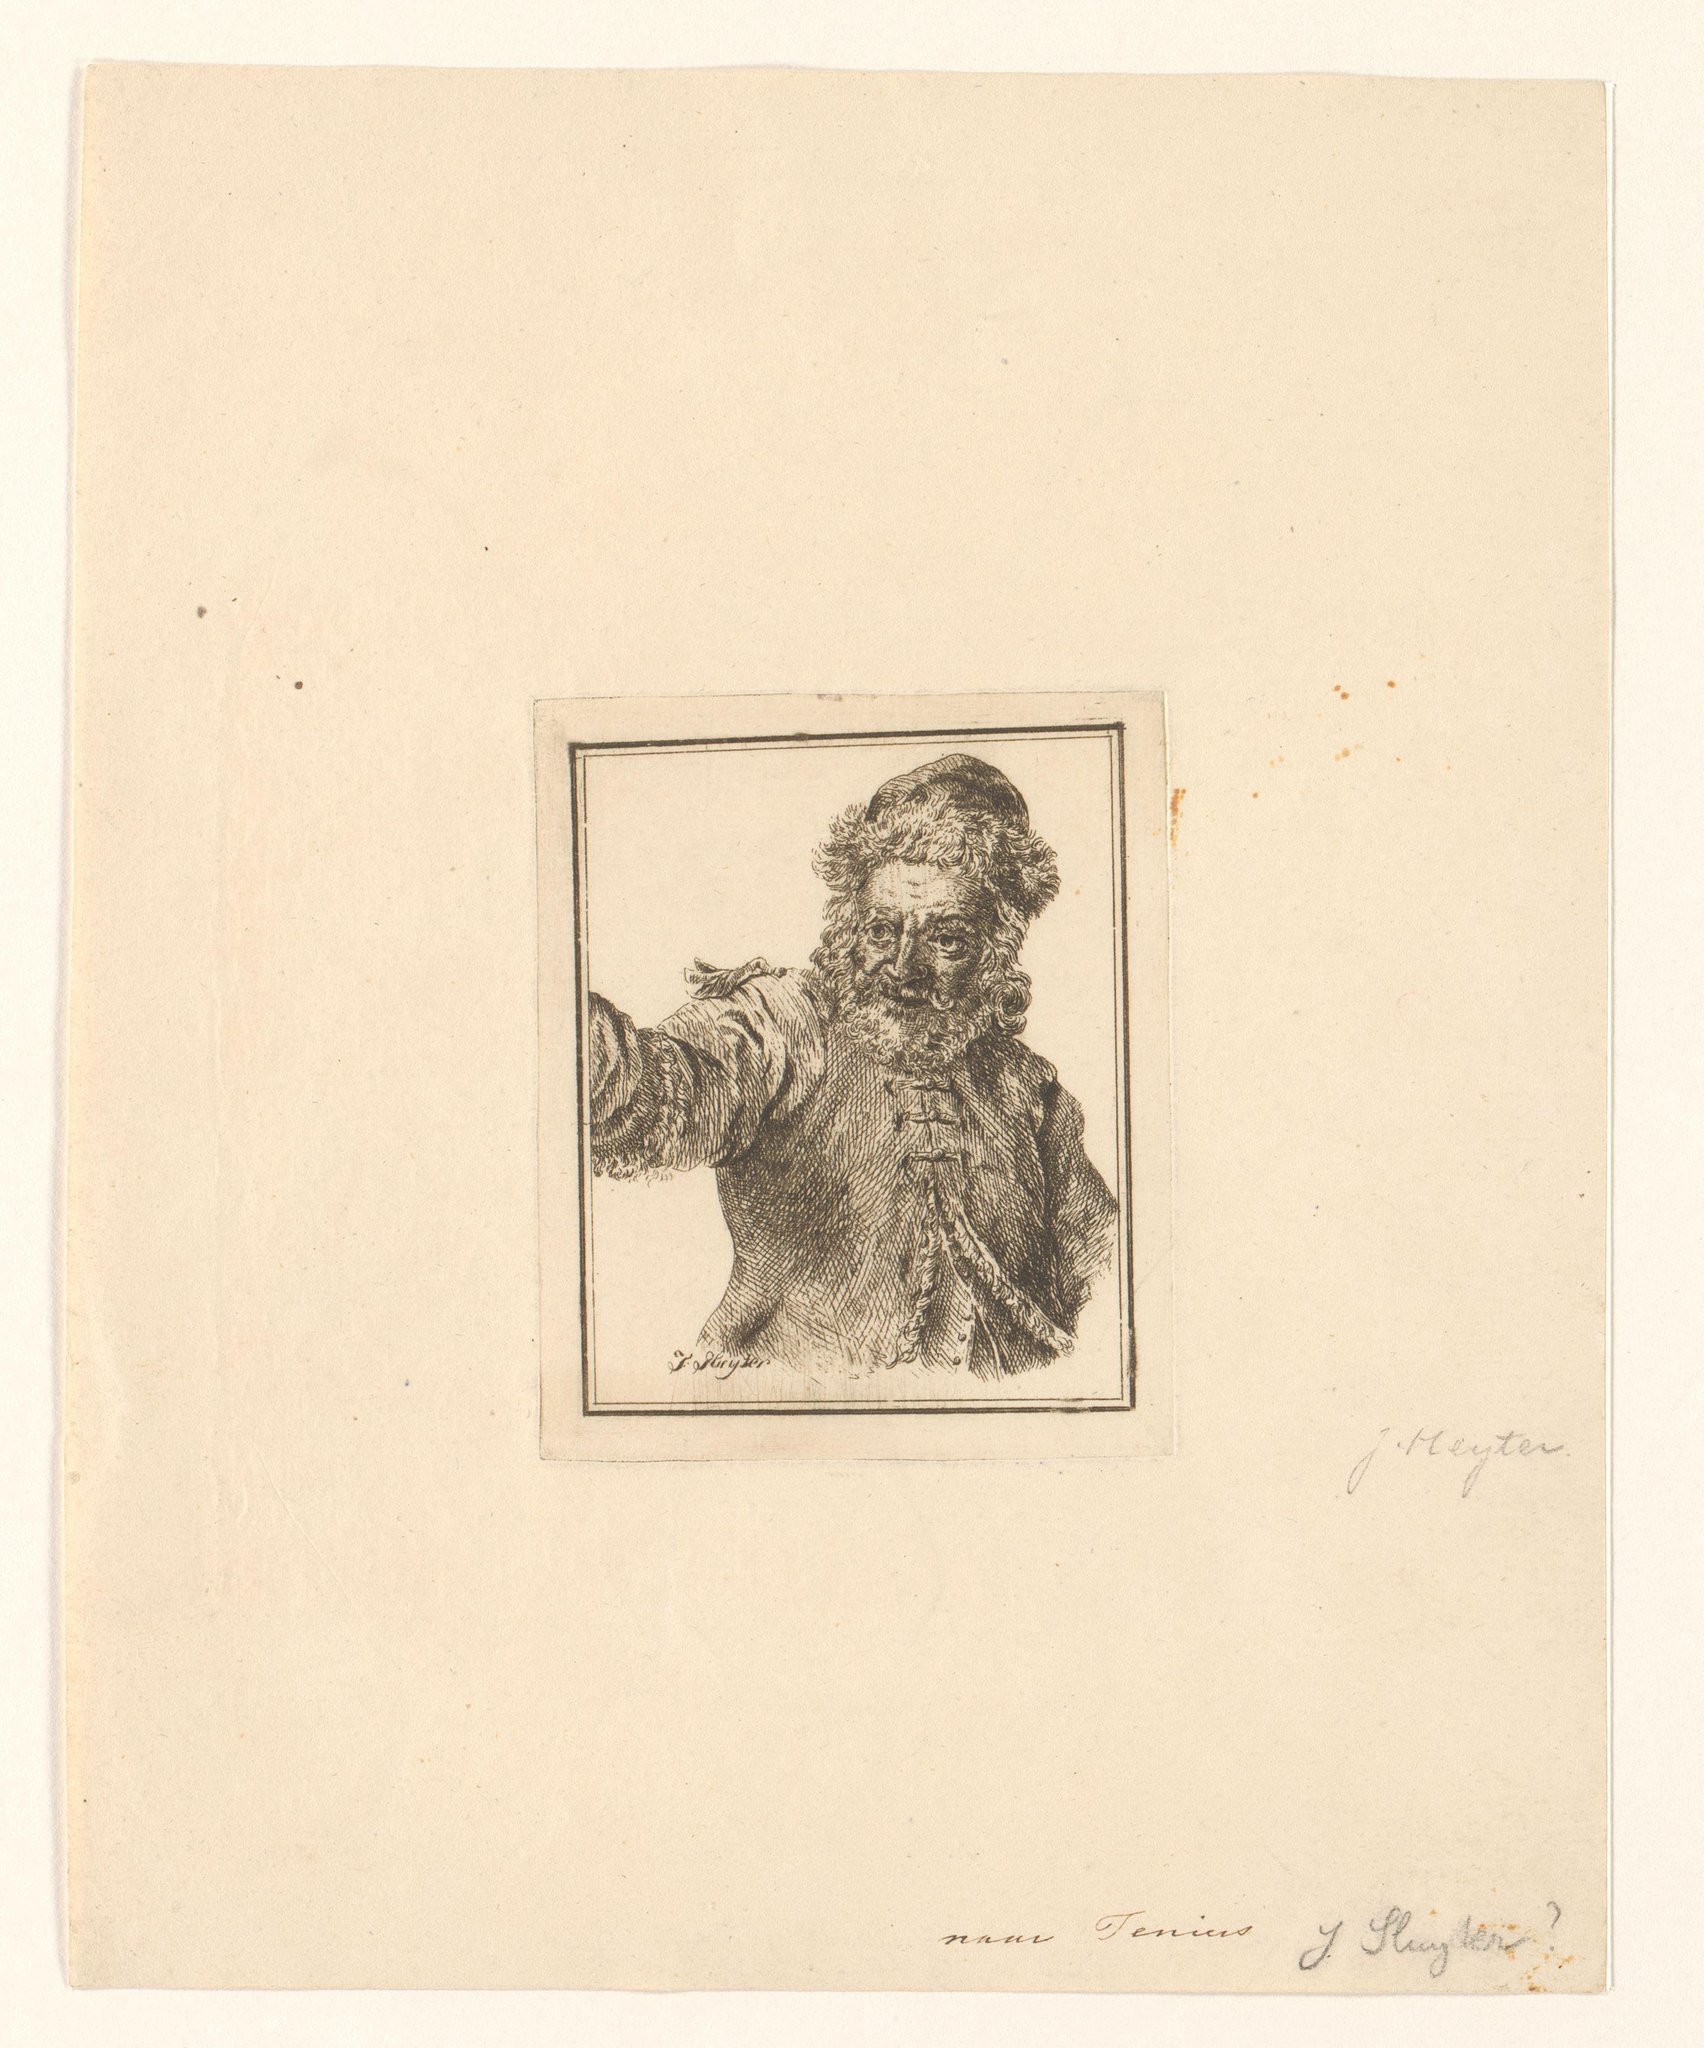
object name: print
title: Man met bontmuts en baard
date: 1700-1799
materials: paper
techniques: etching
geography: netherlands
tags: head-gear (with name), beard, arm stretched forward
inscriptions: inscription: ‘naar Teniers’, collector's mark: Lugt 2228, signature: ‘J.(?) Sl(?)uyter’, collector's mark: Lugt 2227